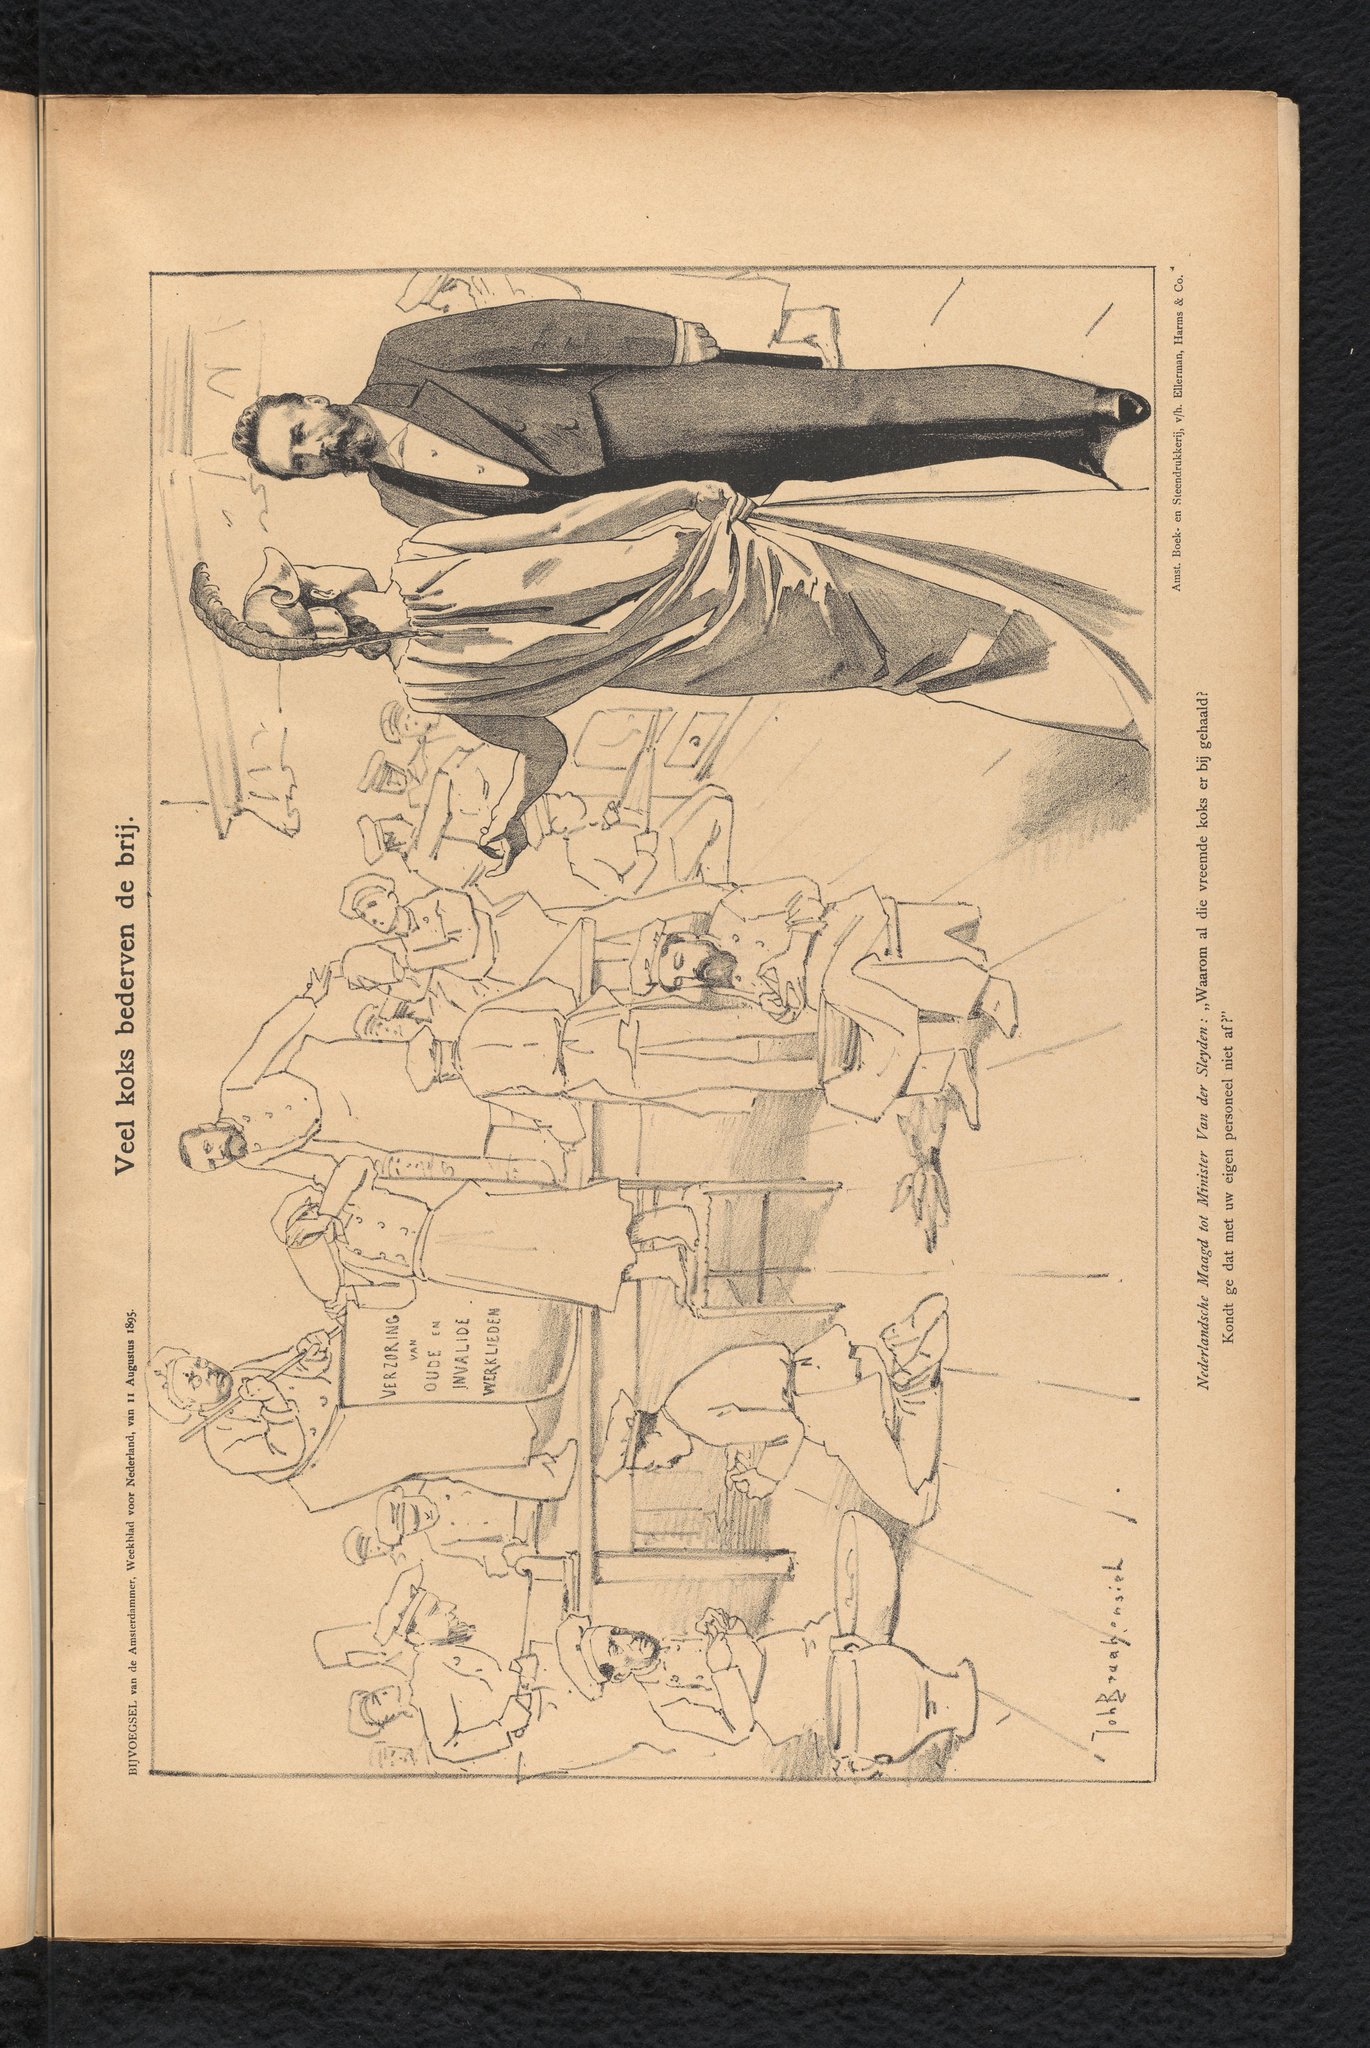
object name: cartoon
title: Veel koks bederven de brij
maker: johan braakensiek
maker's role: draughtsman, print maker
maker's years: 1858-1940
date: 1895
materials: paper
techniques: lithograph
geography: netherlands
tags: deventer, the hague, minister ~ government, kitchen, personifications of countries, nations, states, districts, etc., kitchen-personnel, political caricatures and satires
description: De Nederlandse Maagd vraagt aan Philippe Willem van der Sleyden, minister van Waterstaat, Handel en Nijverheid, waarom er zoveel koks in zijn keuken bezig zijn met het bereiden in een grote ketel van de 'Verzorging van Oude en Invalide Werklieden'.